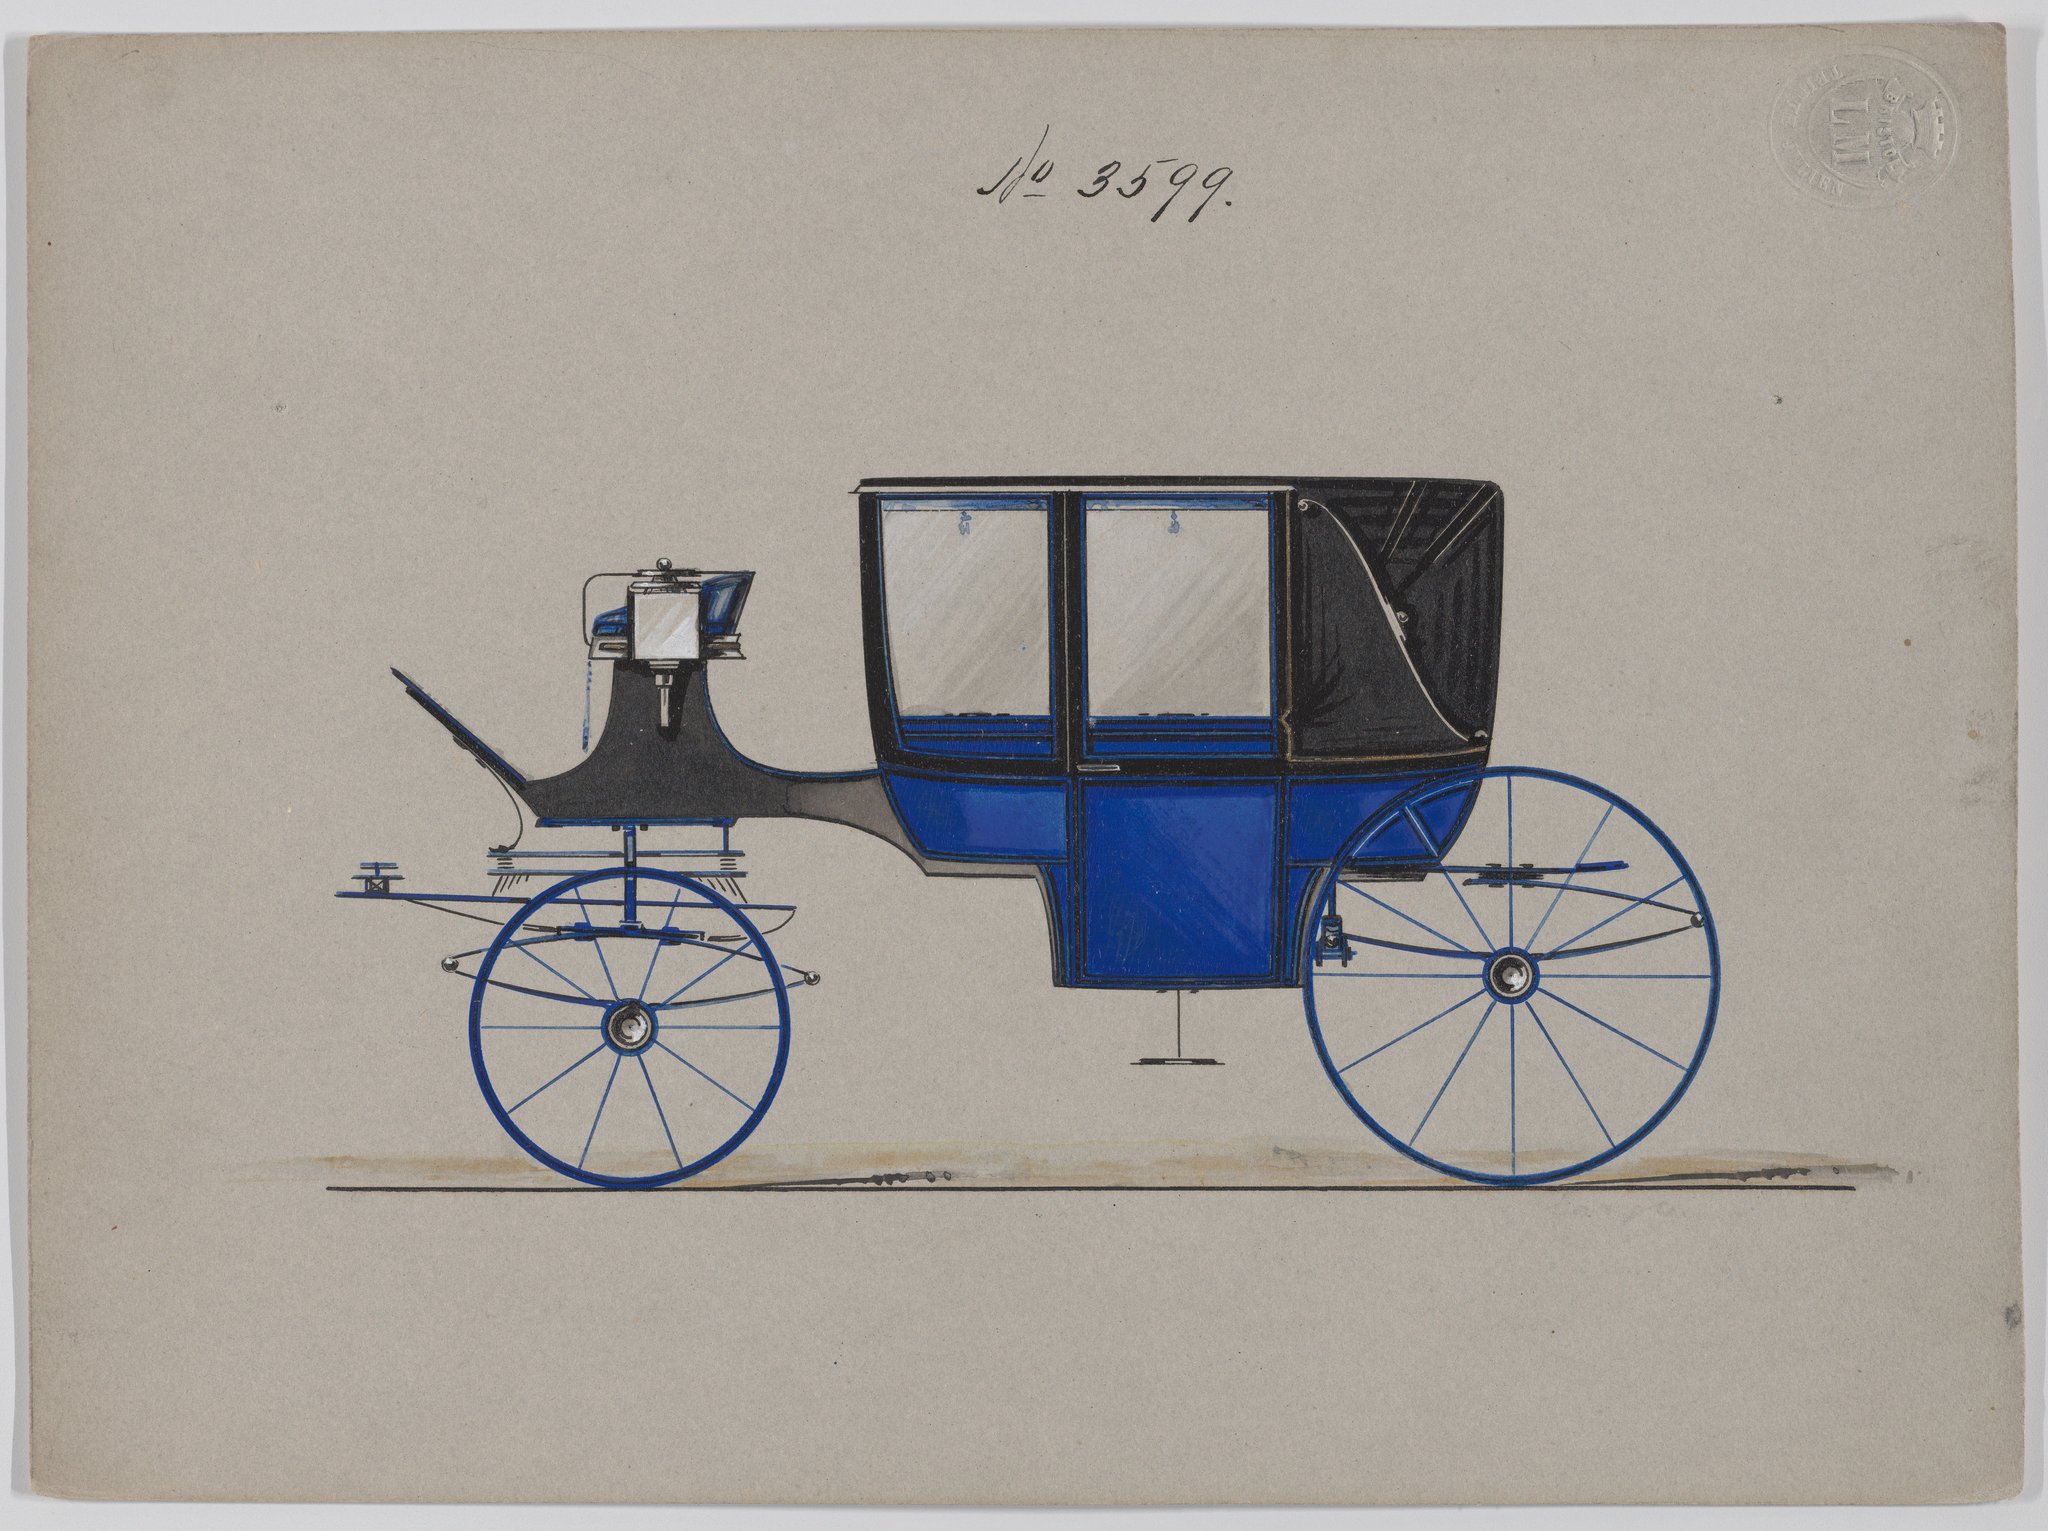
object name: drawing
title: Design for Landau, No. 3599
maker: brewster & co.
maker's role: manufacturer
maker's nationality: american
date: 1880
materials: gouache, gum arabic, ink, watercolor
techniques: pen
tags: carriages